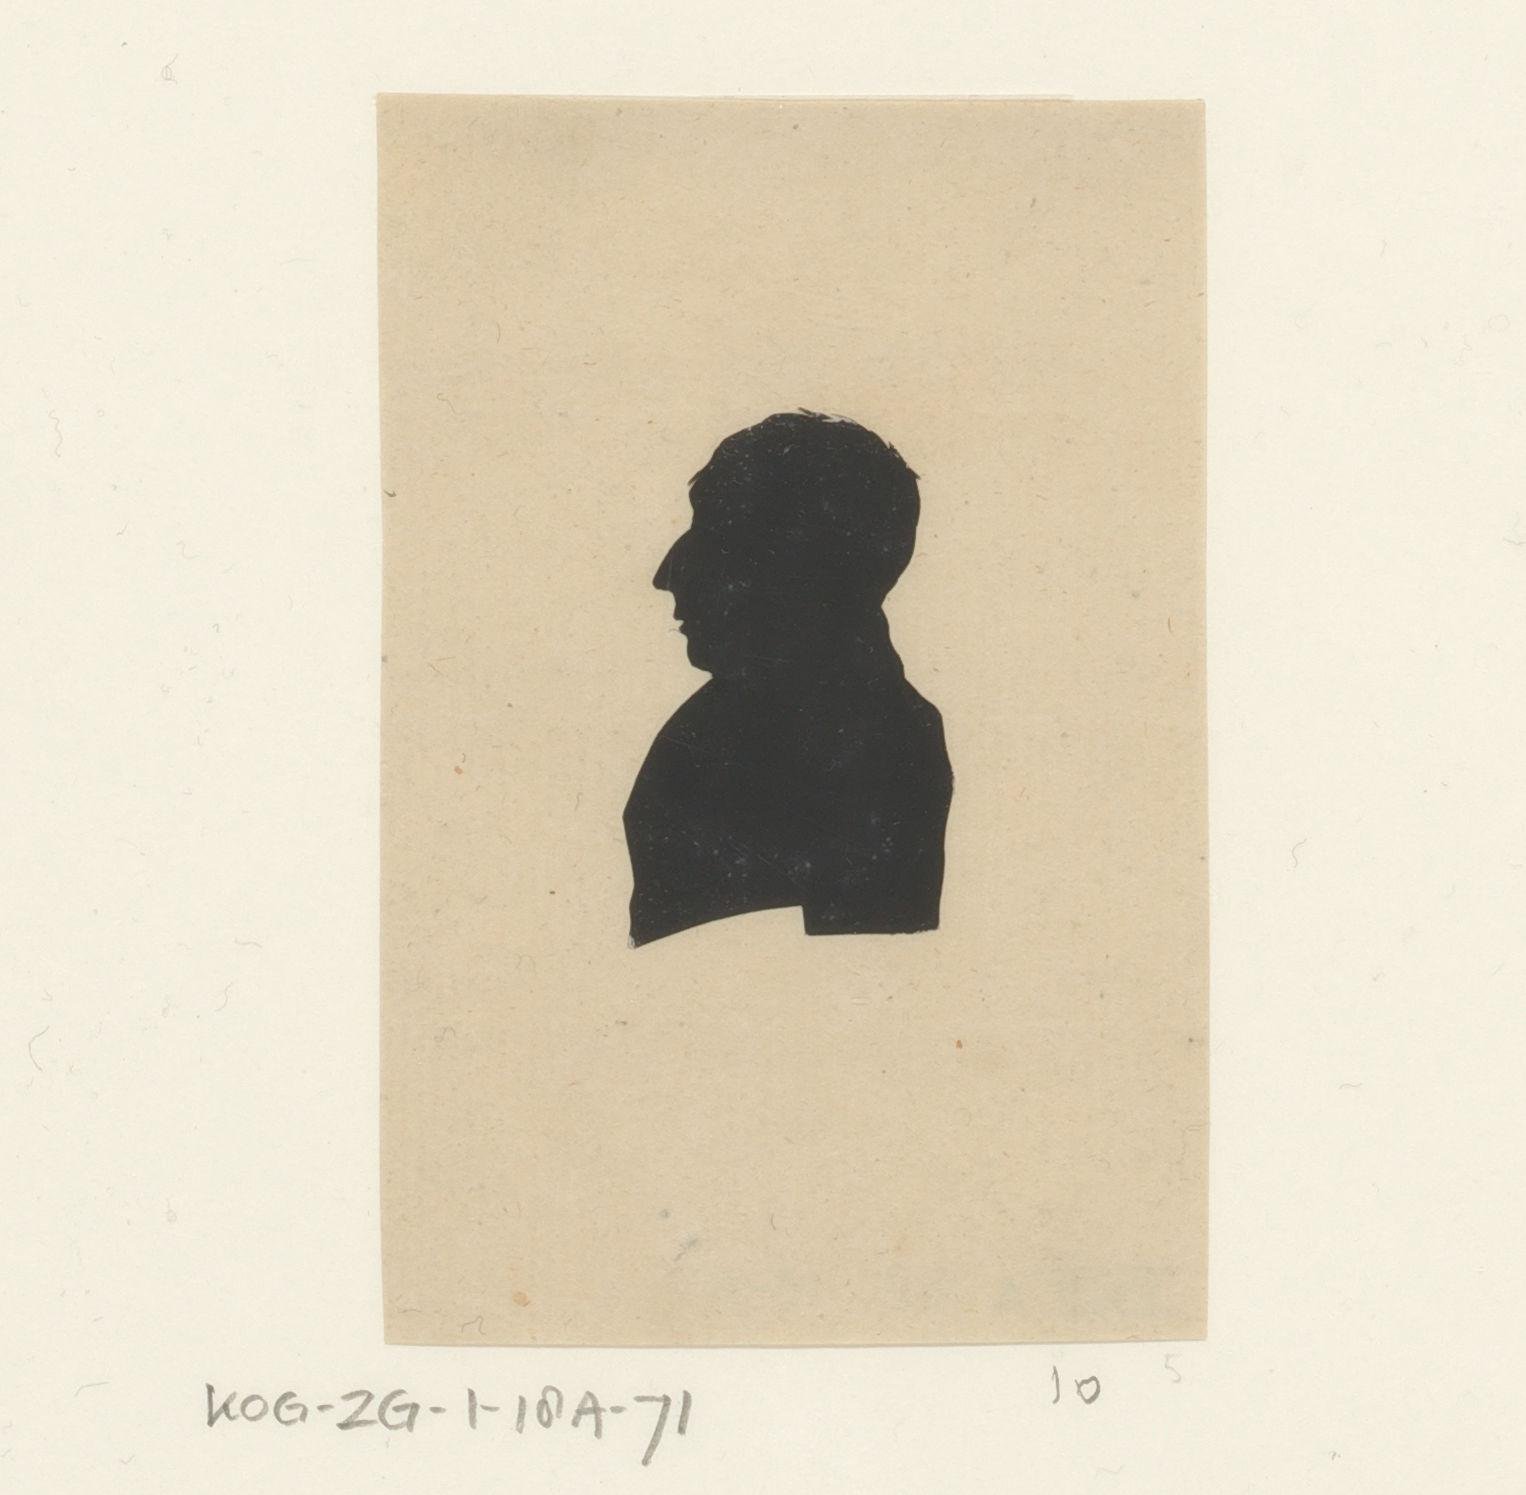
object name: silhouette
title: Silhouetportret van een onbekende man, mogelijk H.P. Stambke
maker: Anonymous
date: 1800-1820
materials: paper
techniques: snipping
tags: historical persons not known by name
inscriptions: stamp, collector's mark: Lugt 1641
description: Silhouetportret naar links. Onderwerpsrubrieken binnen de Atlas Zeden en Gewoonten: Schoone kunsten, Silhouetportretten.